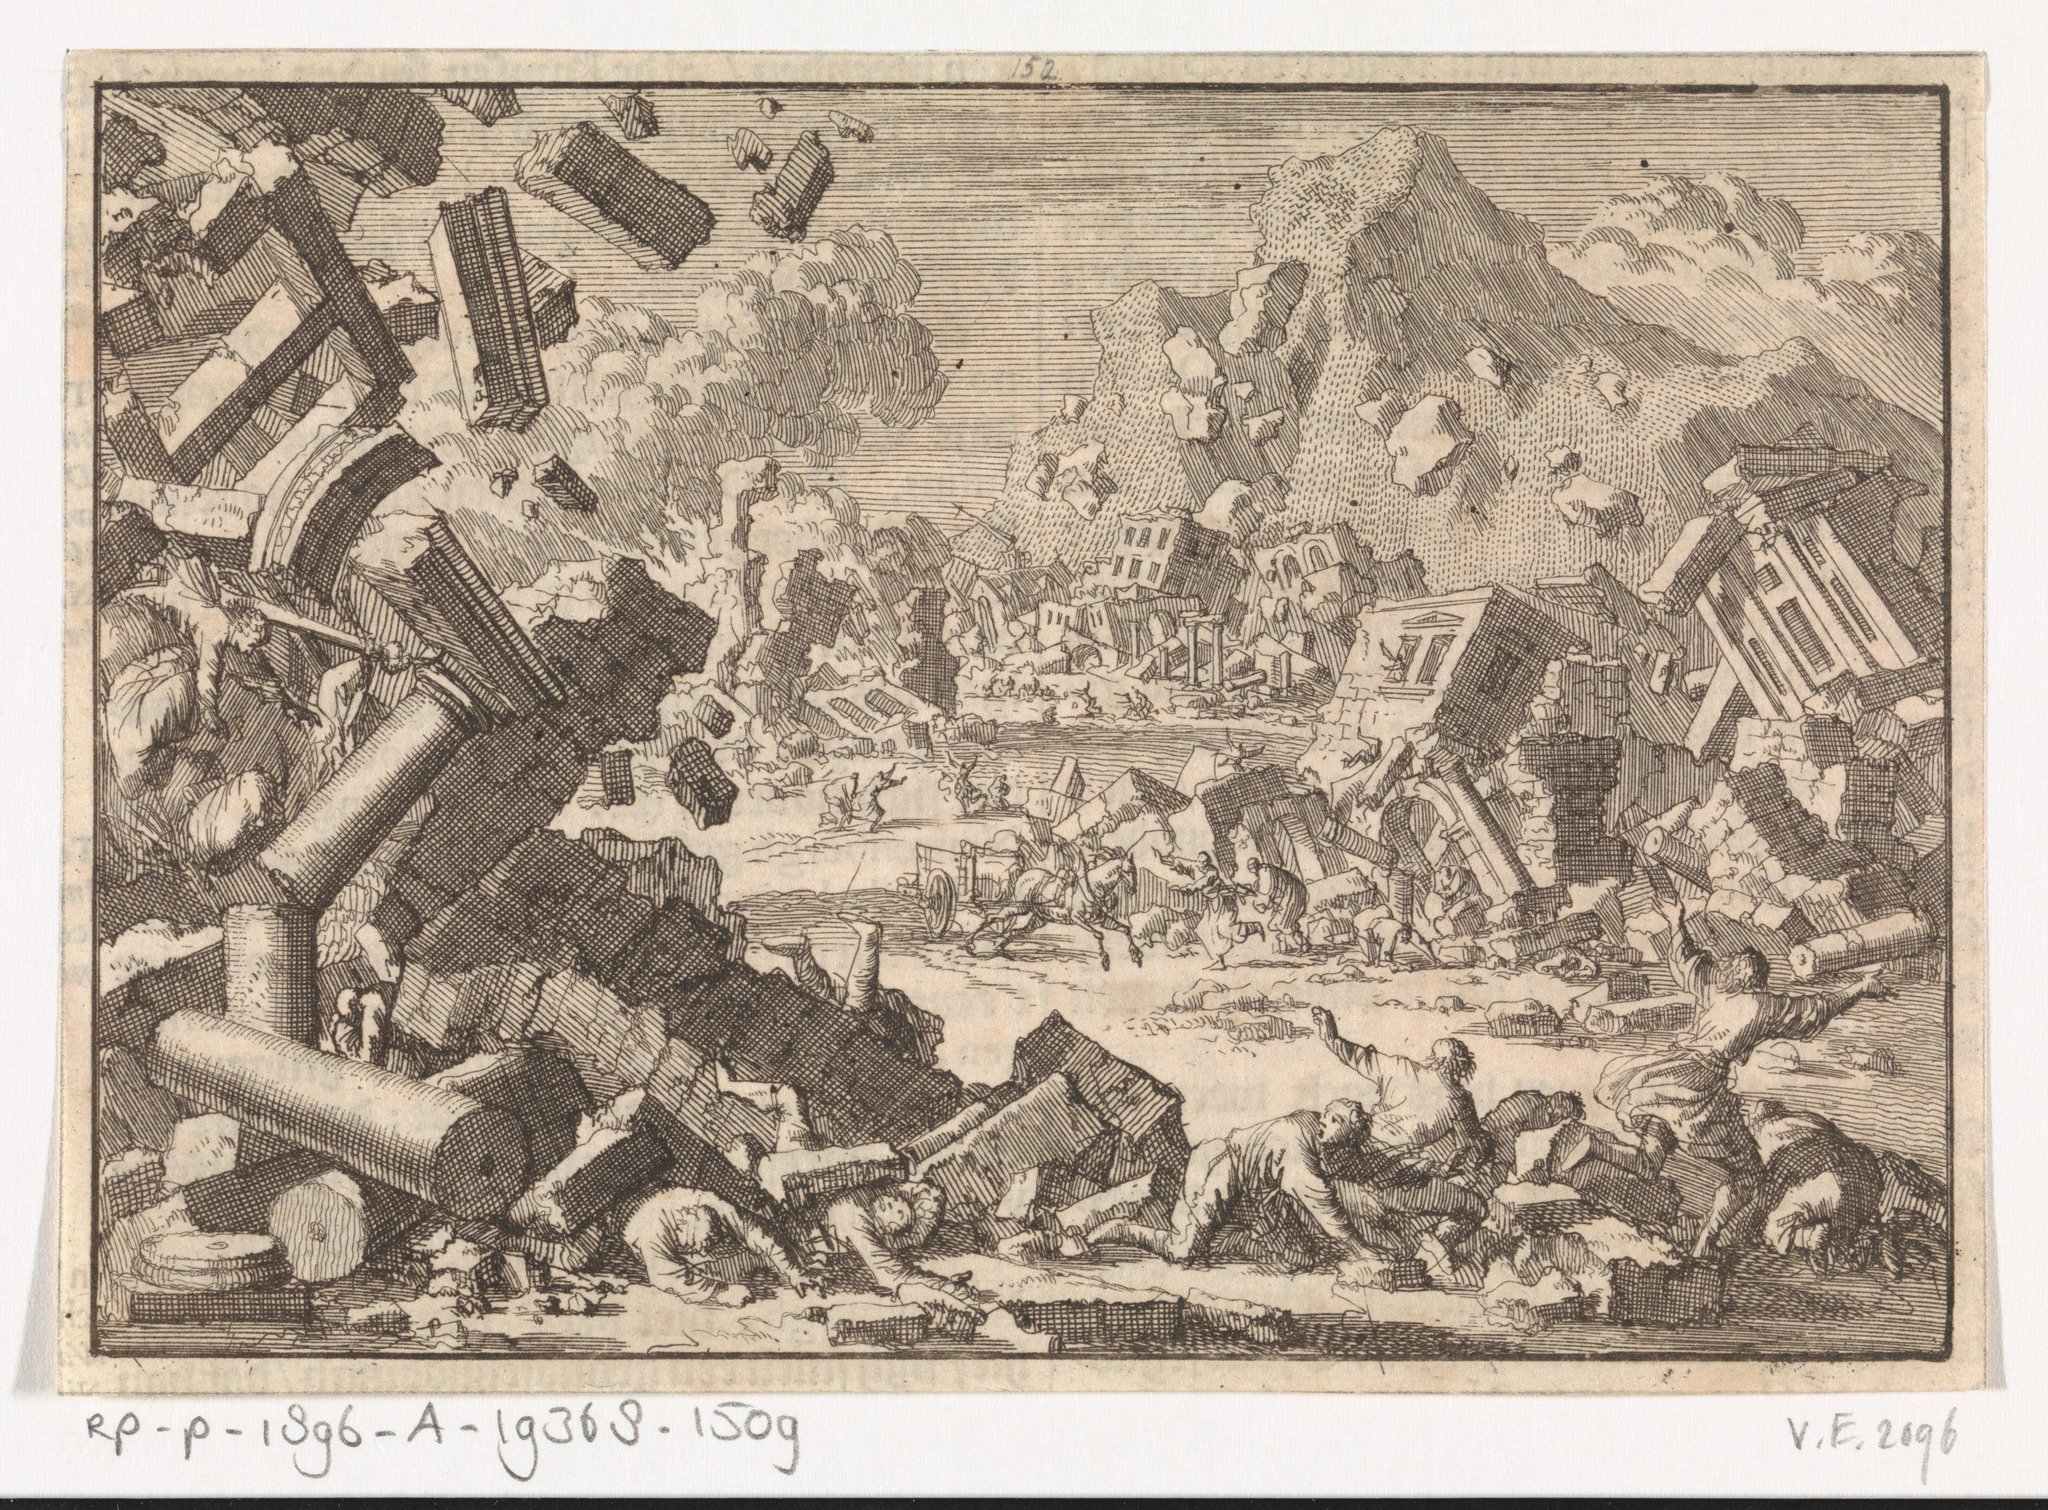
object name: book illustration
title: Aardbeving te Ragusa, 1667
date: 1698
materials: paper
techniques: etching, letterpress printing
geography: leiden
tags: earthquake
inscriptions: collector's mark: Lugt 2228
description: Illustratie uit: Gottfried, Johann Ludwig. Historische kronyck; vervattende een (...) beschrijvingh der aldergedenckwaerdigste geschiedenissen des weerelds, van den aenvangh der scheppingh tot (...) 1576 (2 delen). Leiden: Pieter van der Aa, 1698, dl. II, p. 965.